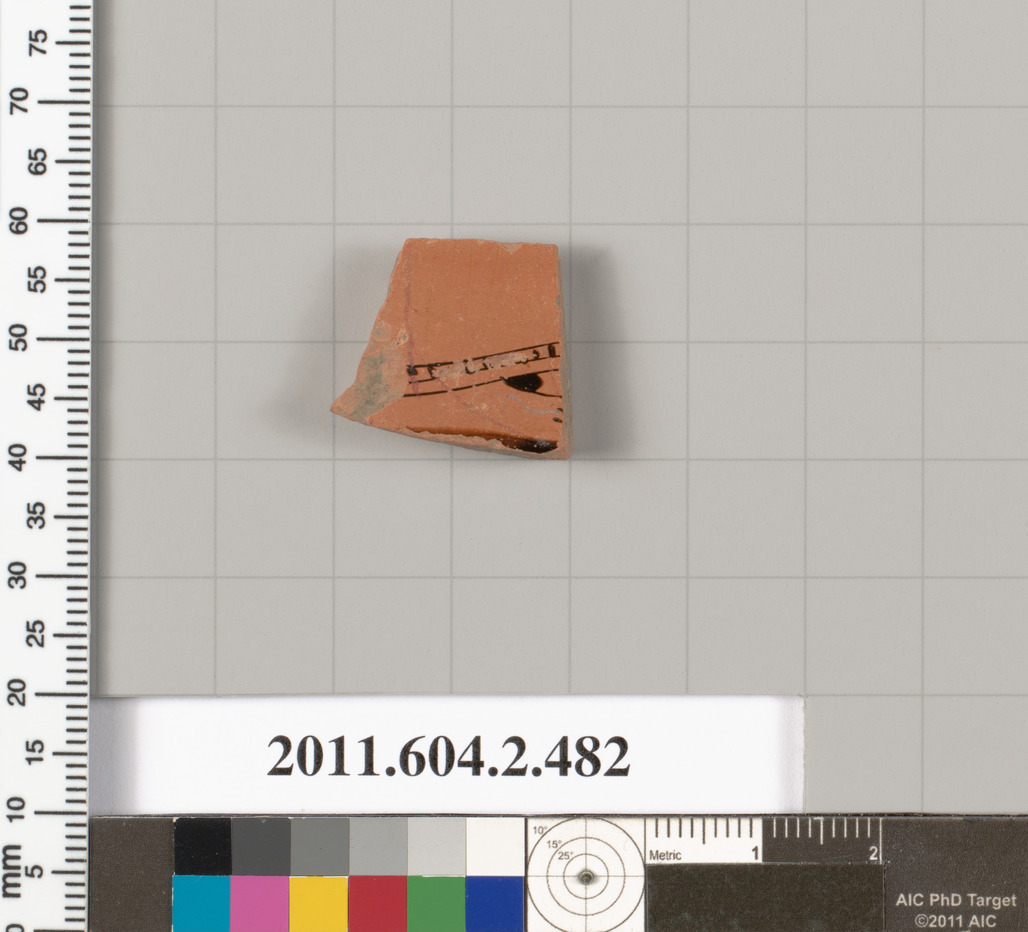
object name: column krater fragment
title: Terracotta fragment of a column-krater (bowl for mixing wine and water)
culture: greek, attic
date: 460-440 BCE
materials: terracotta